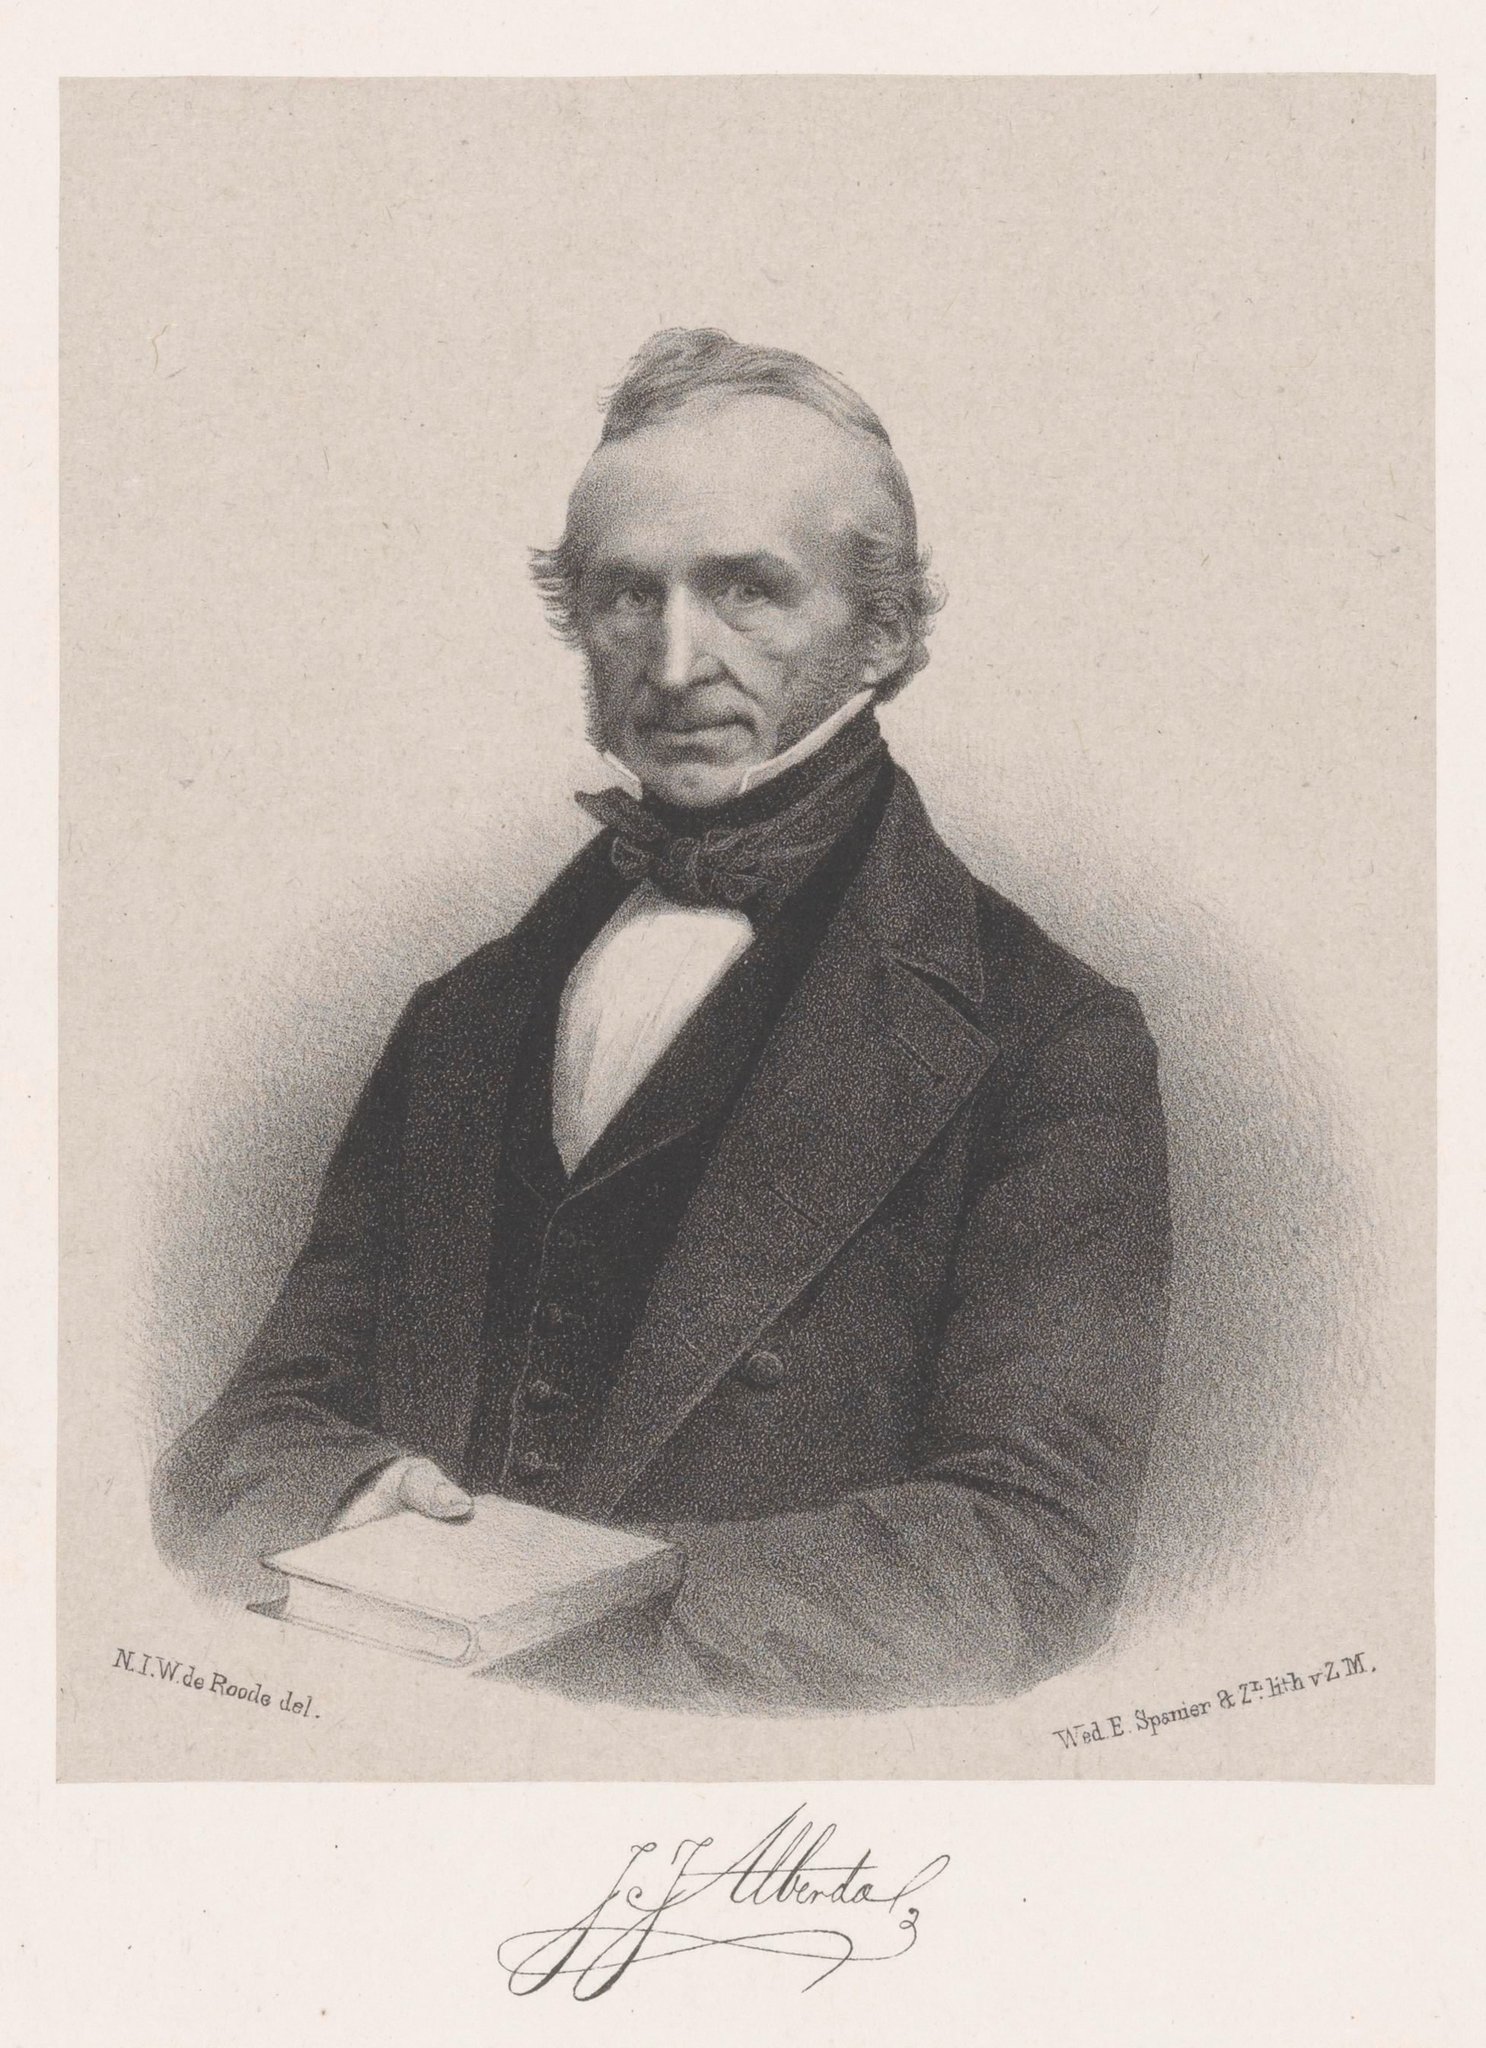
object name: print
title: Portret van Jacob Jansz. Alberda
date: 1863-1883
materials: paper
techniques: lithograph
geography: the hague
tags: amsterdam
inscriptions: collector's mark: Lugt 2228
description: Portret van Jacob Jansz. Alberda. Hij heeft een boek in zijn rechterhand. In de ondermarge zijn handtekening.